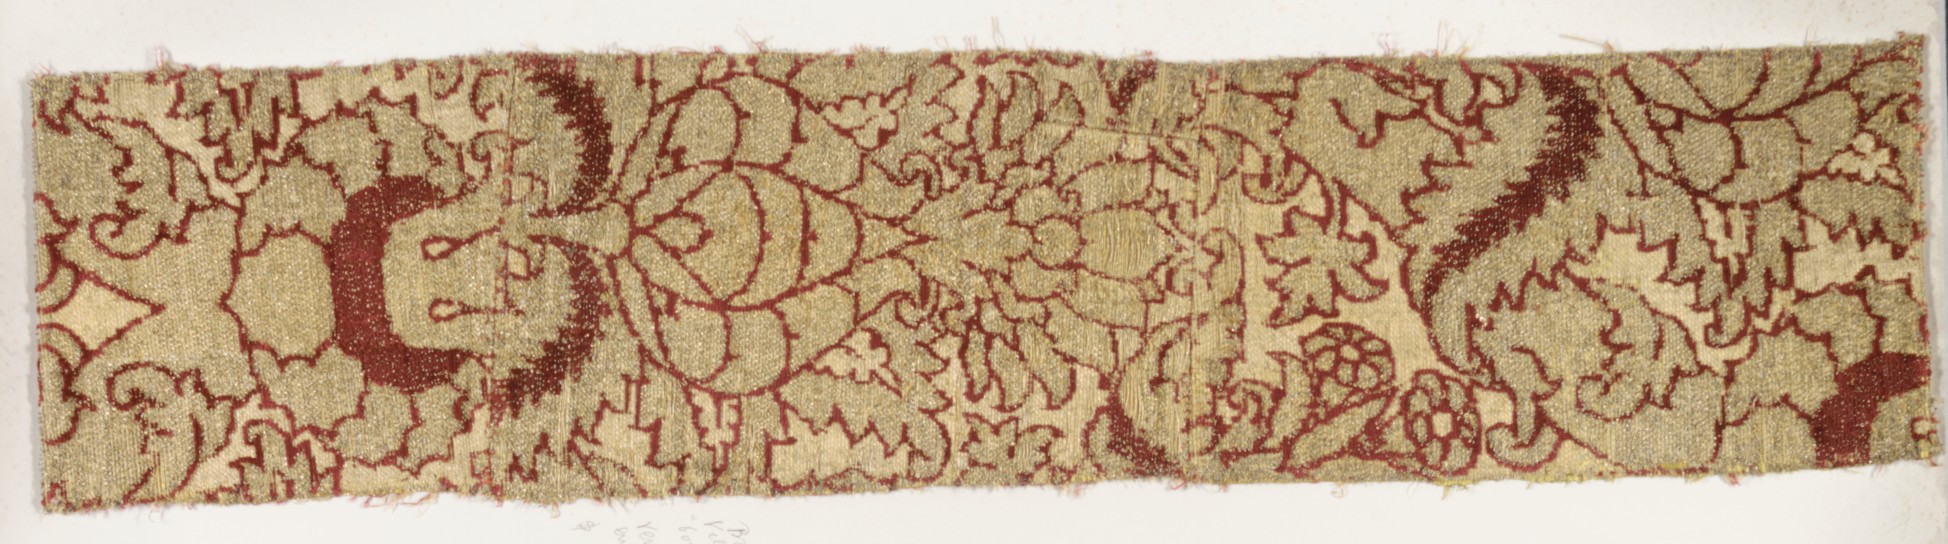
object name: fragment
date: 1467-1500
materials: metal thread, silk